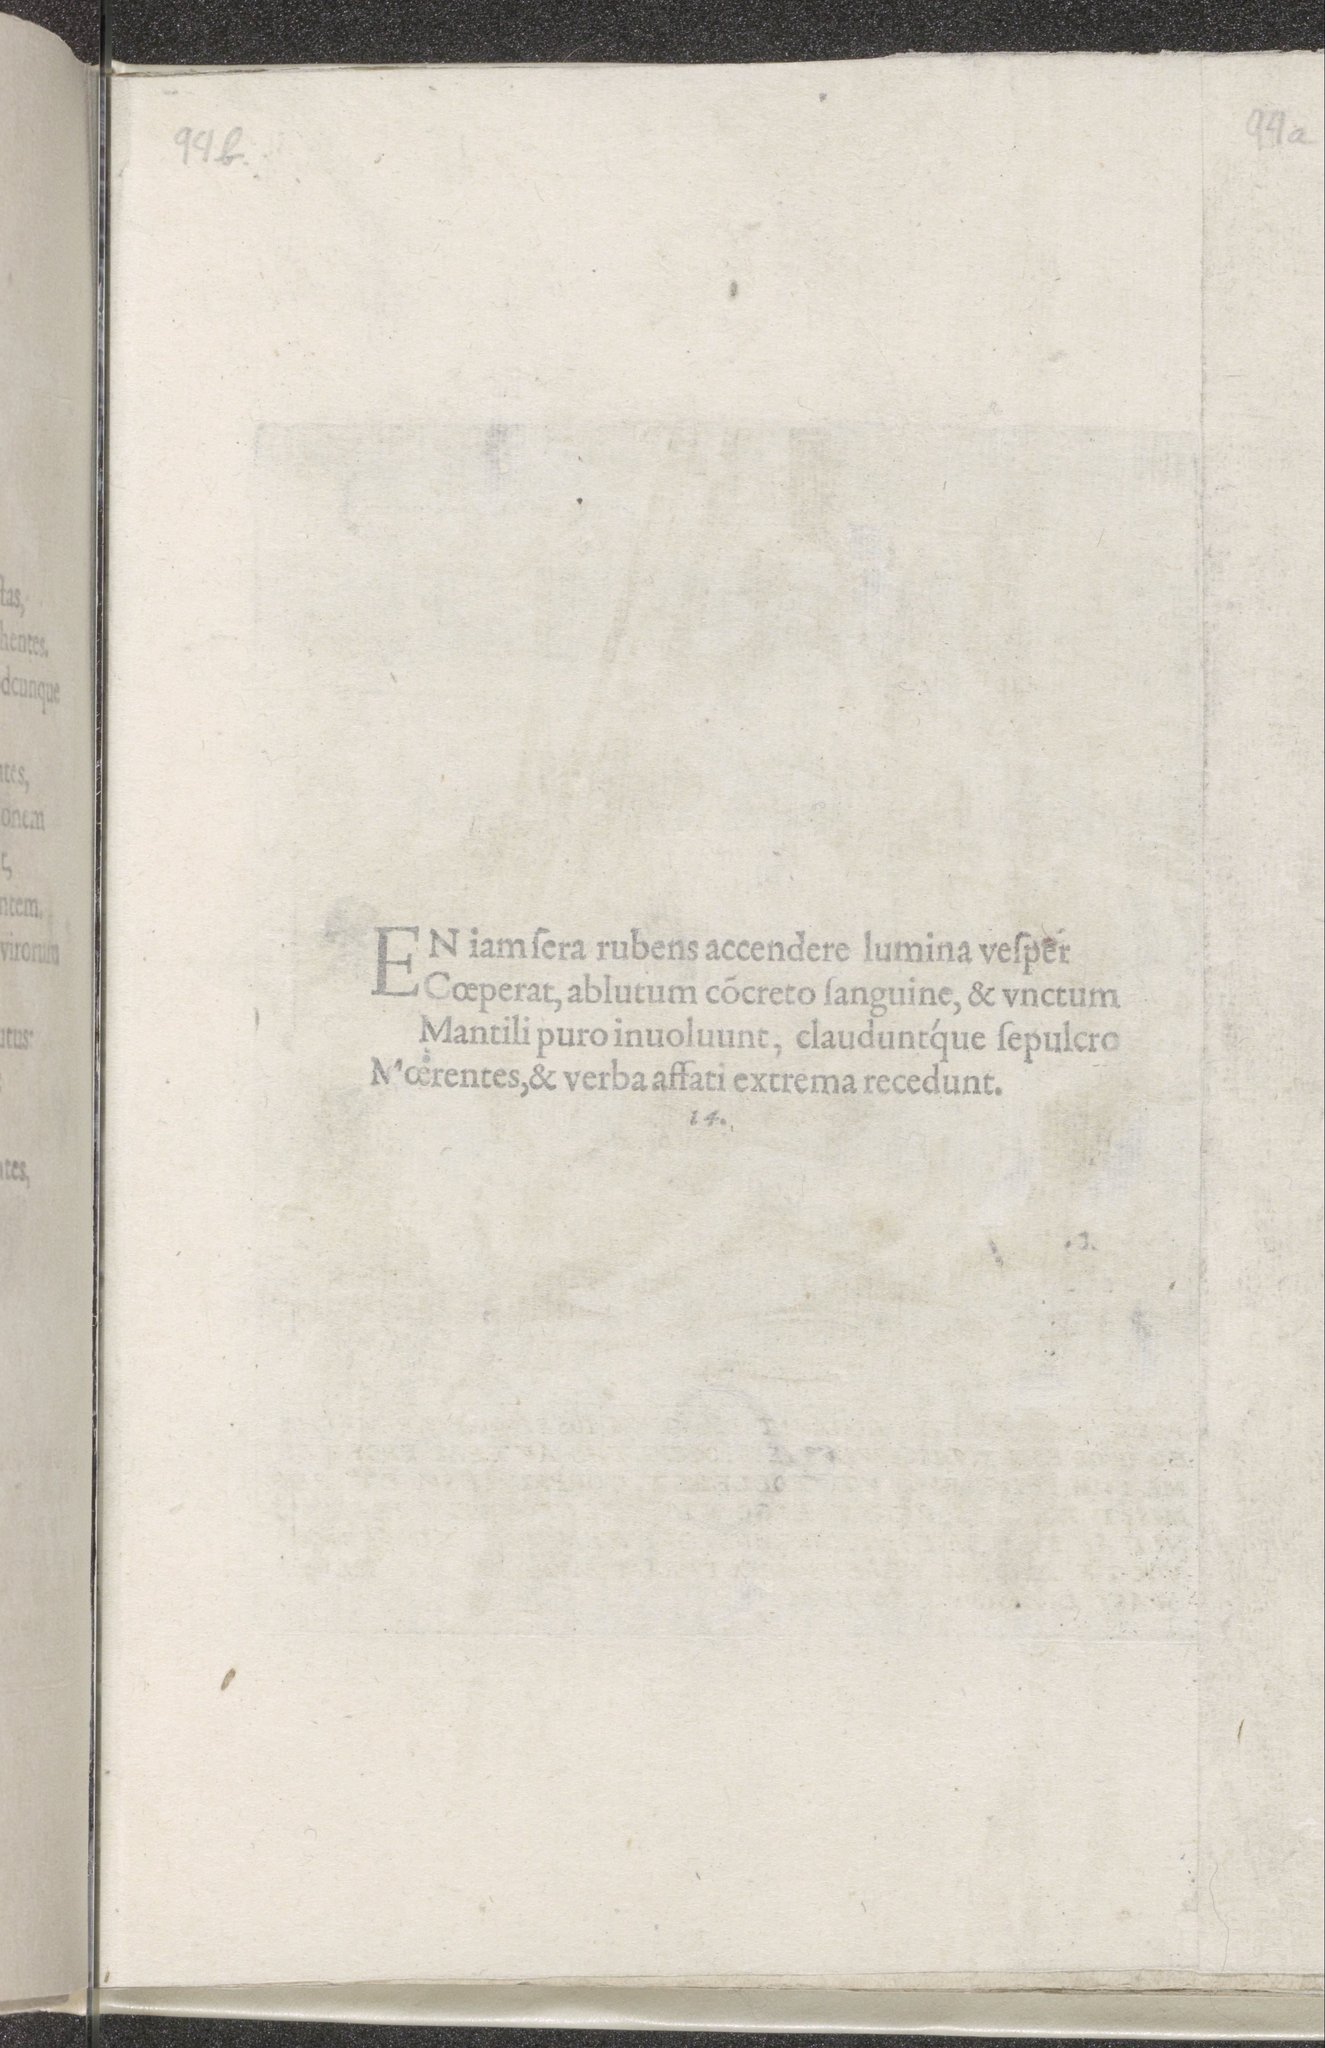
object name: text sheet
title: Passie van Christus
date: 1572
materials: paper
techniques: letterpress printing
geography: antwerp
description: Tijdens de restauratie in 1988 bleek dat op de achterzijde van de prenten van de Passie-serie van Wierix Latijnse teksten in boekdruk staan. Deze vormen, wanneer op de juiste wijze in boekvorm gebonden (wat nu in het Heemskerck-album niet het geval is), een toelichting op de passievoorstellingen. Om de teksten zichtbaar te laten zijn de prenten bij de restauratie niet meer met de achterzijde op elkaar geplakt.